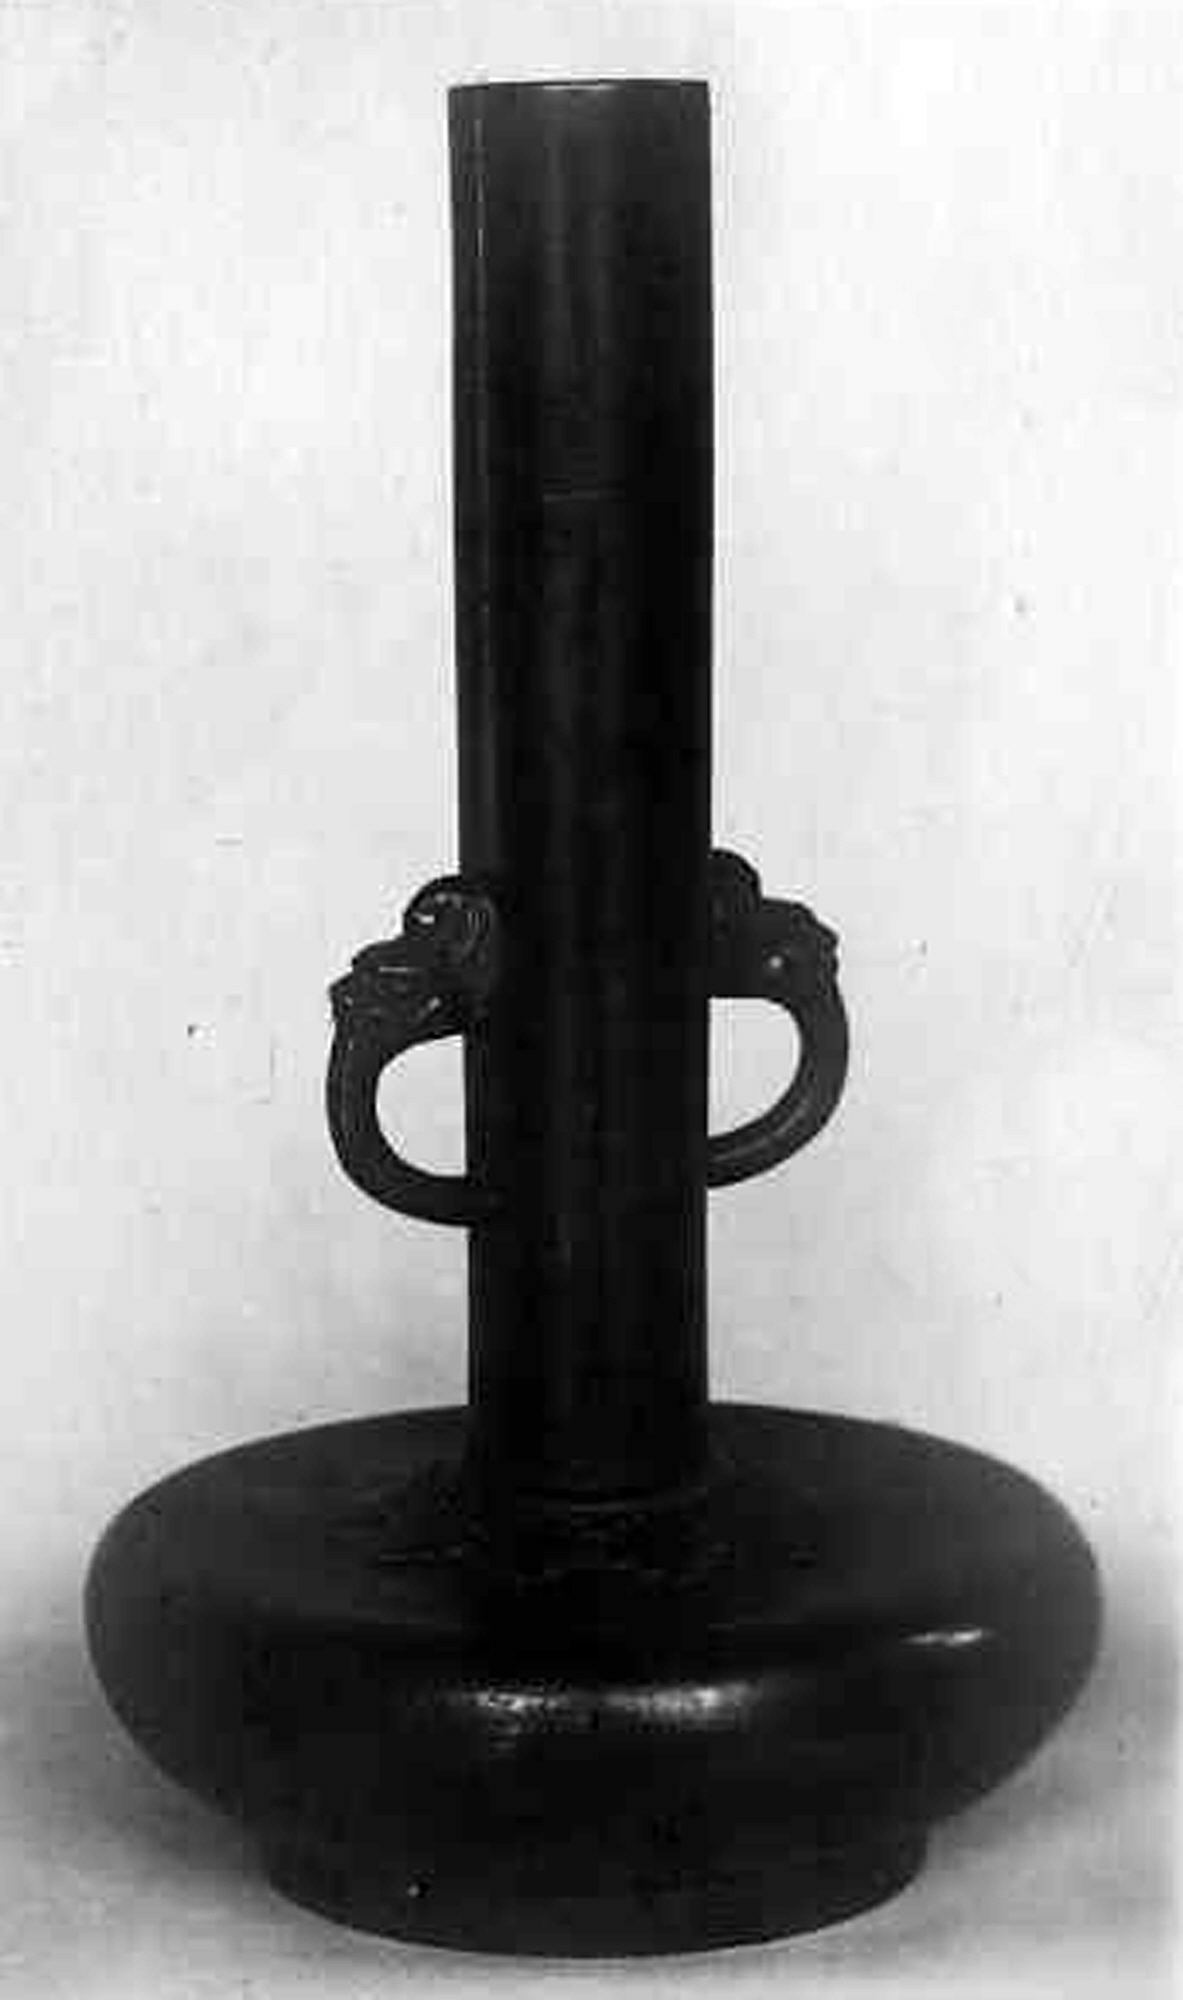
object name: vase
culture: japanese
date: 1734-1900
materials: bronze